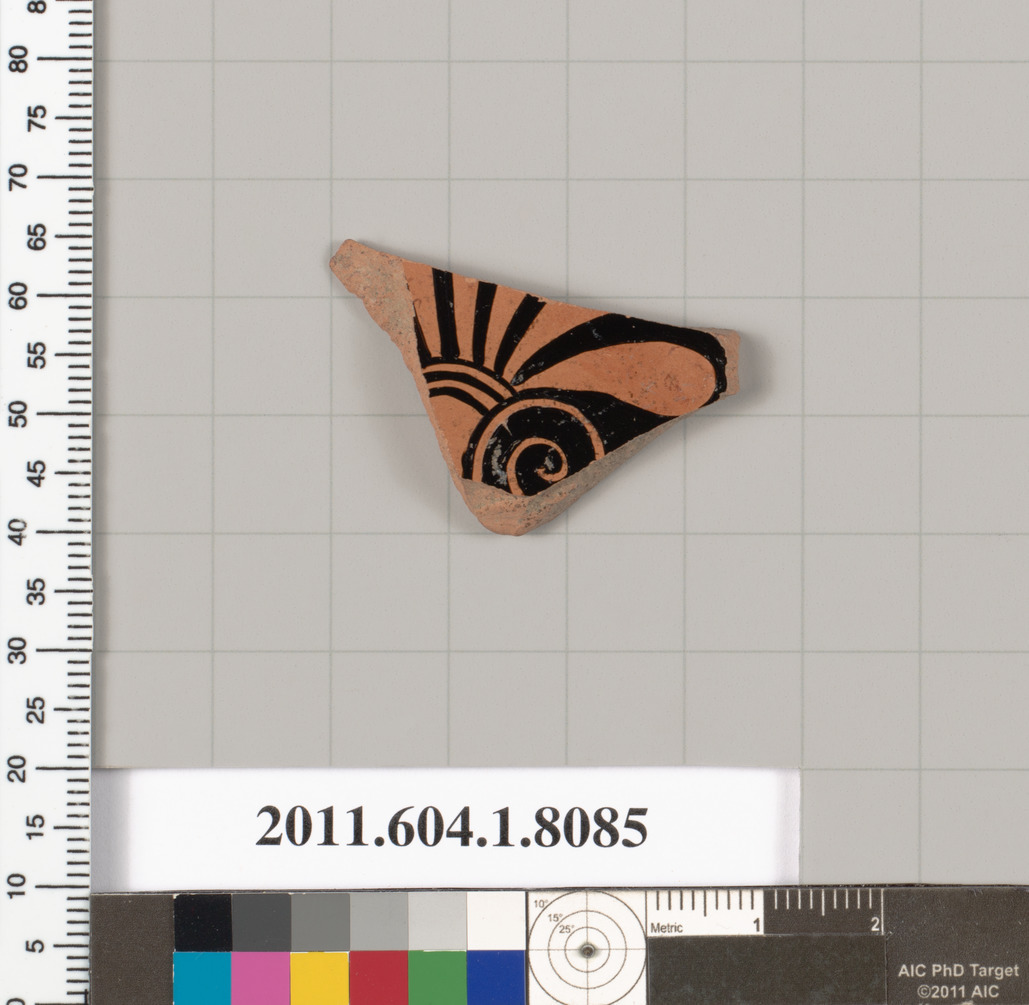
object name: kylix fragment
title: Terracotta fragment of a kylix (drinking cup)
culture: greek, attic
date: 510-500 BCE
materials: terracotta